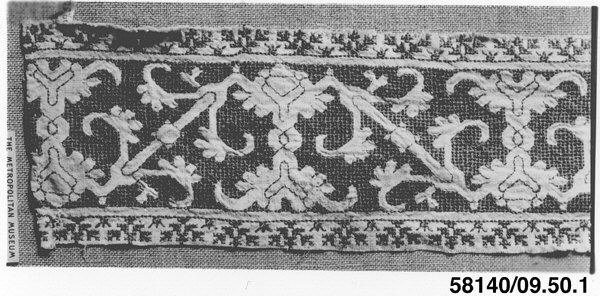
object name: band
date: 1501-1700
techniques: embroidery